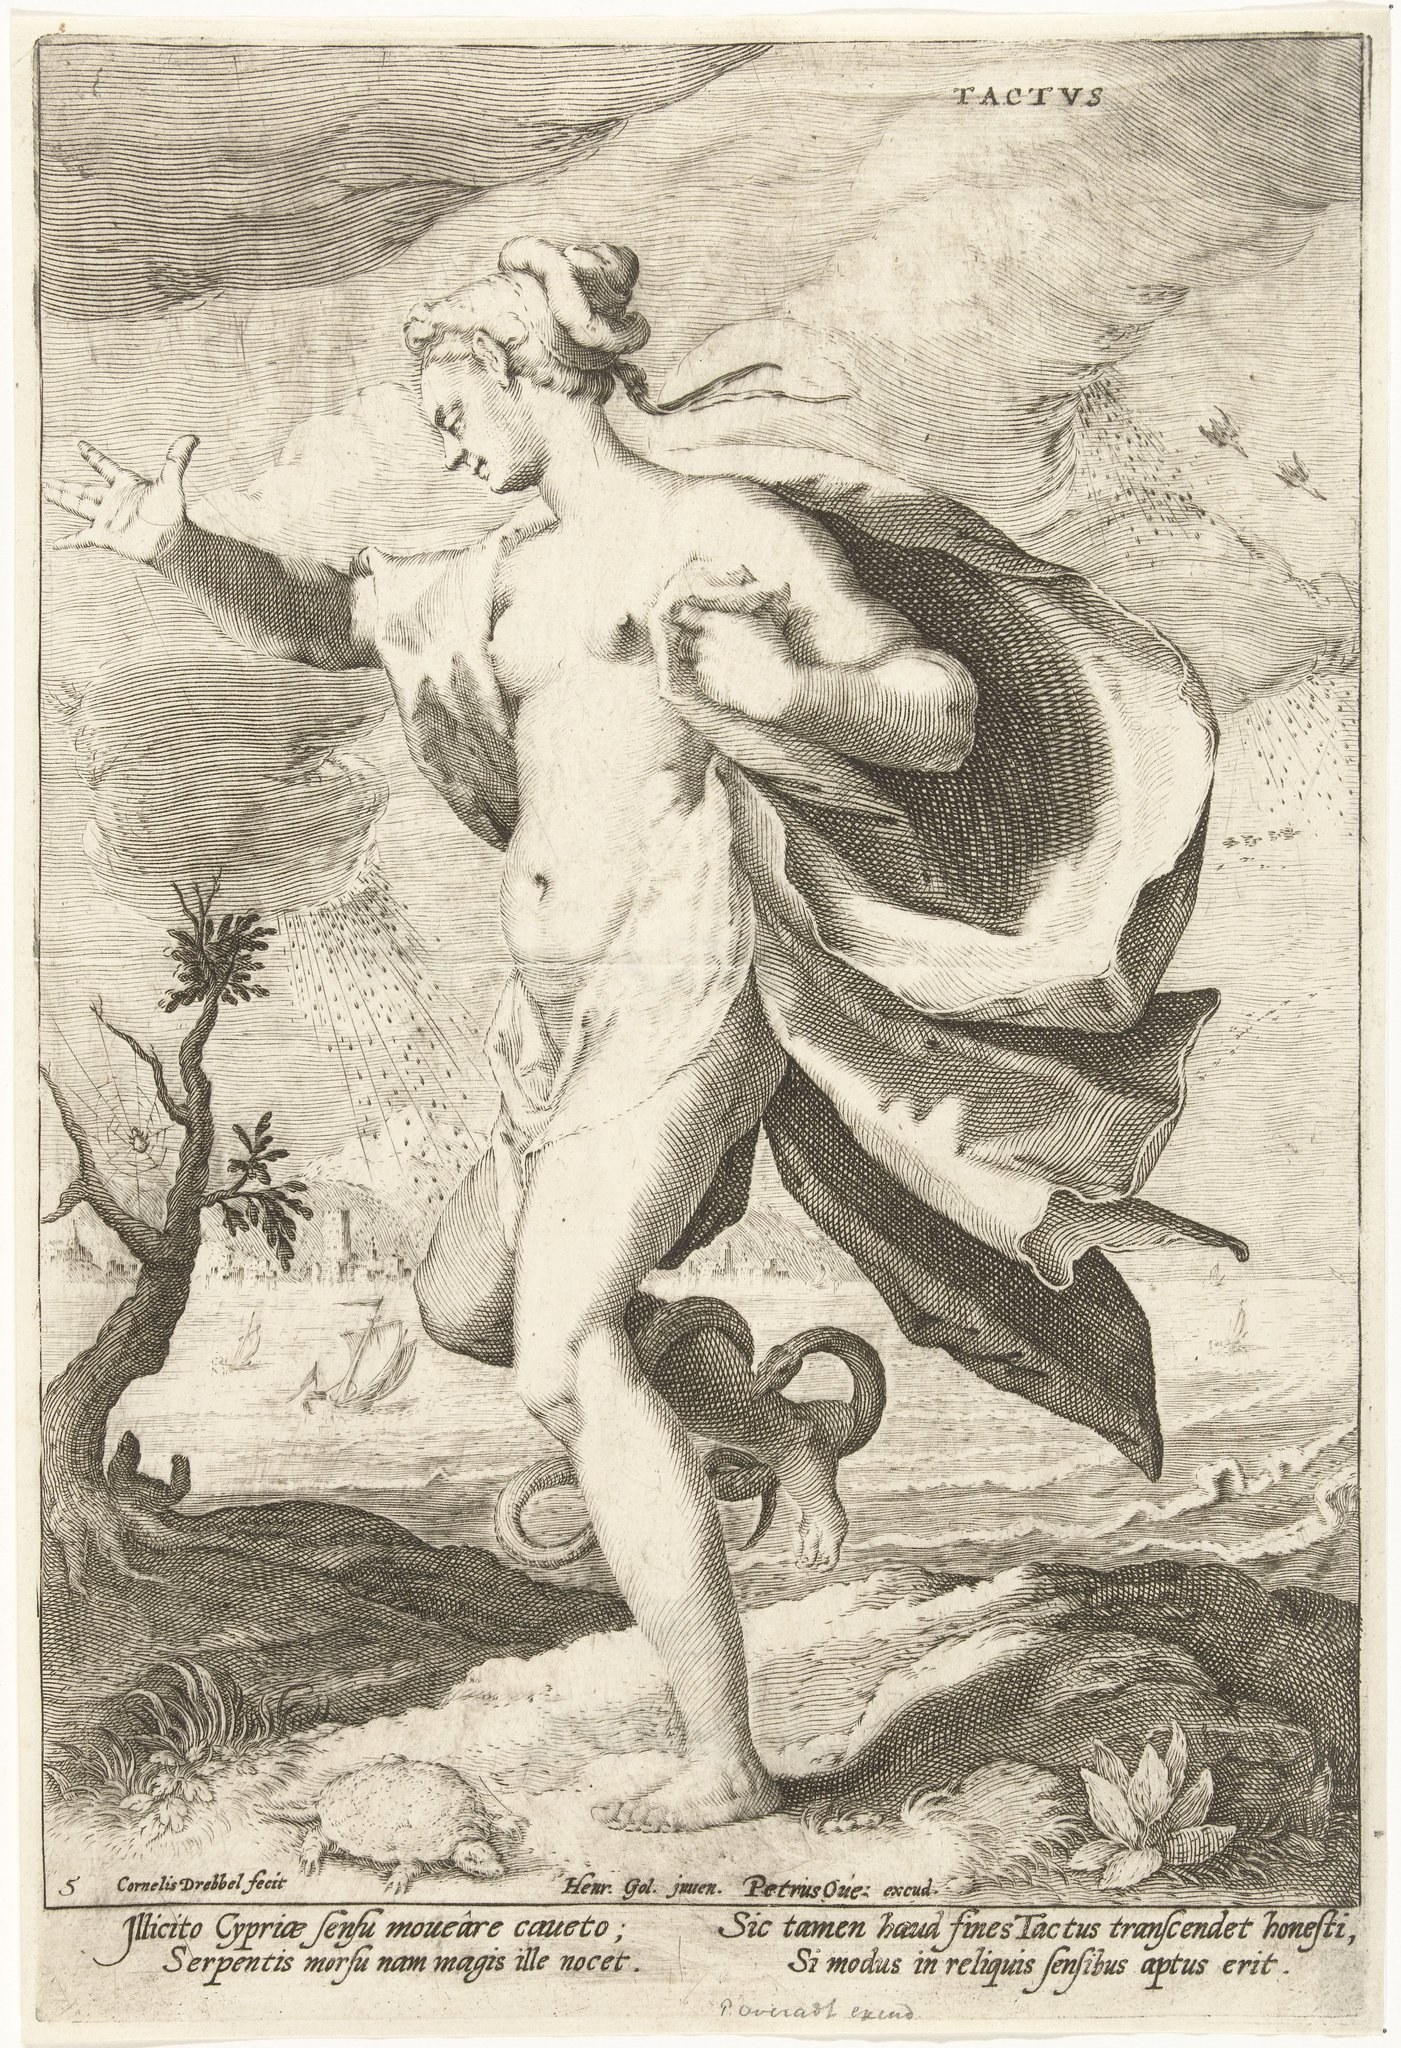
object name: print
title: Tactvs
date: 1596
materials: paper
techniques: engraving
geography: netherlands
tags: feeling (one of the five senses)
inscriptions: caption: ‘Illicito Cypriae sensu...sensibus aptusbn erit.’, collector's mark: Lugt 2228, signature: ‘Cornelis Drebbel fecit’, signature: ‘Henr/ Gol. inven.’, number: ‘5’, title: ‘TACTUS’, address: ‘Petrus Ove: excud.’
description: Personificatie van het Gevoel, een naakte vrouw met een slang om haar rechterbeen loopt in een landschap. Vijfde prent uit een serie met de vijf zintuigen gegraveerd door N.J. Clock en C.J. Drebbel.